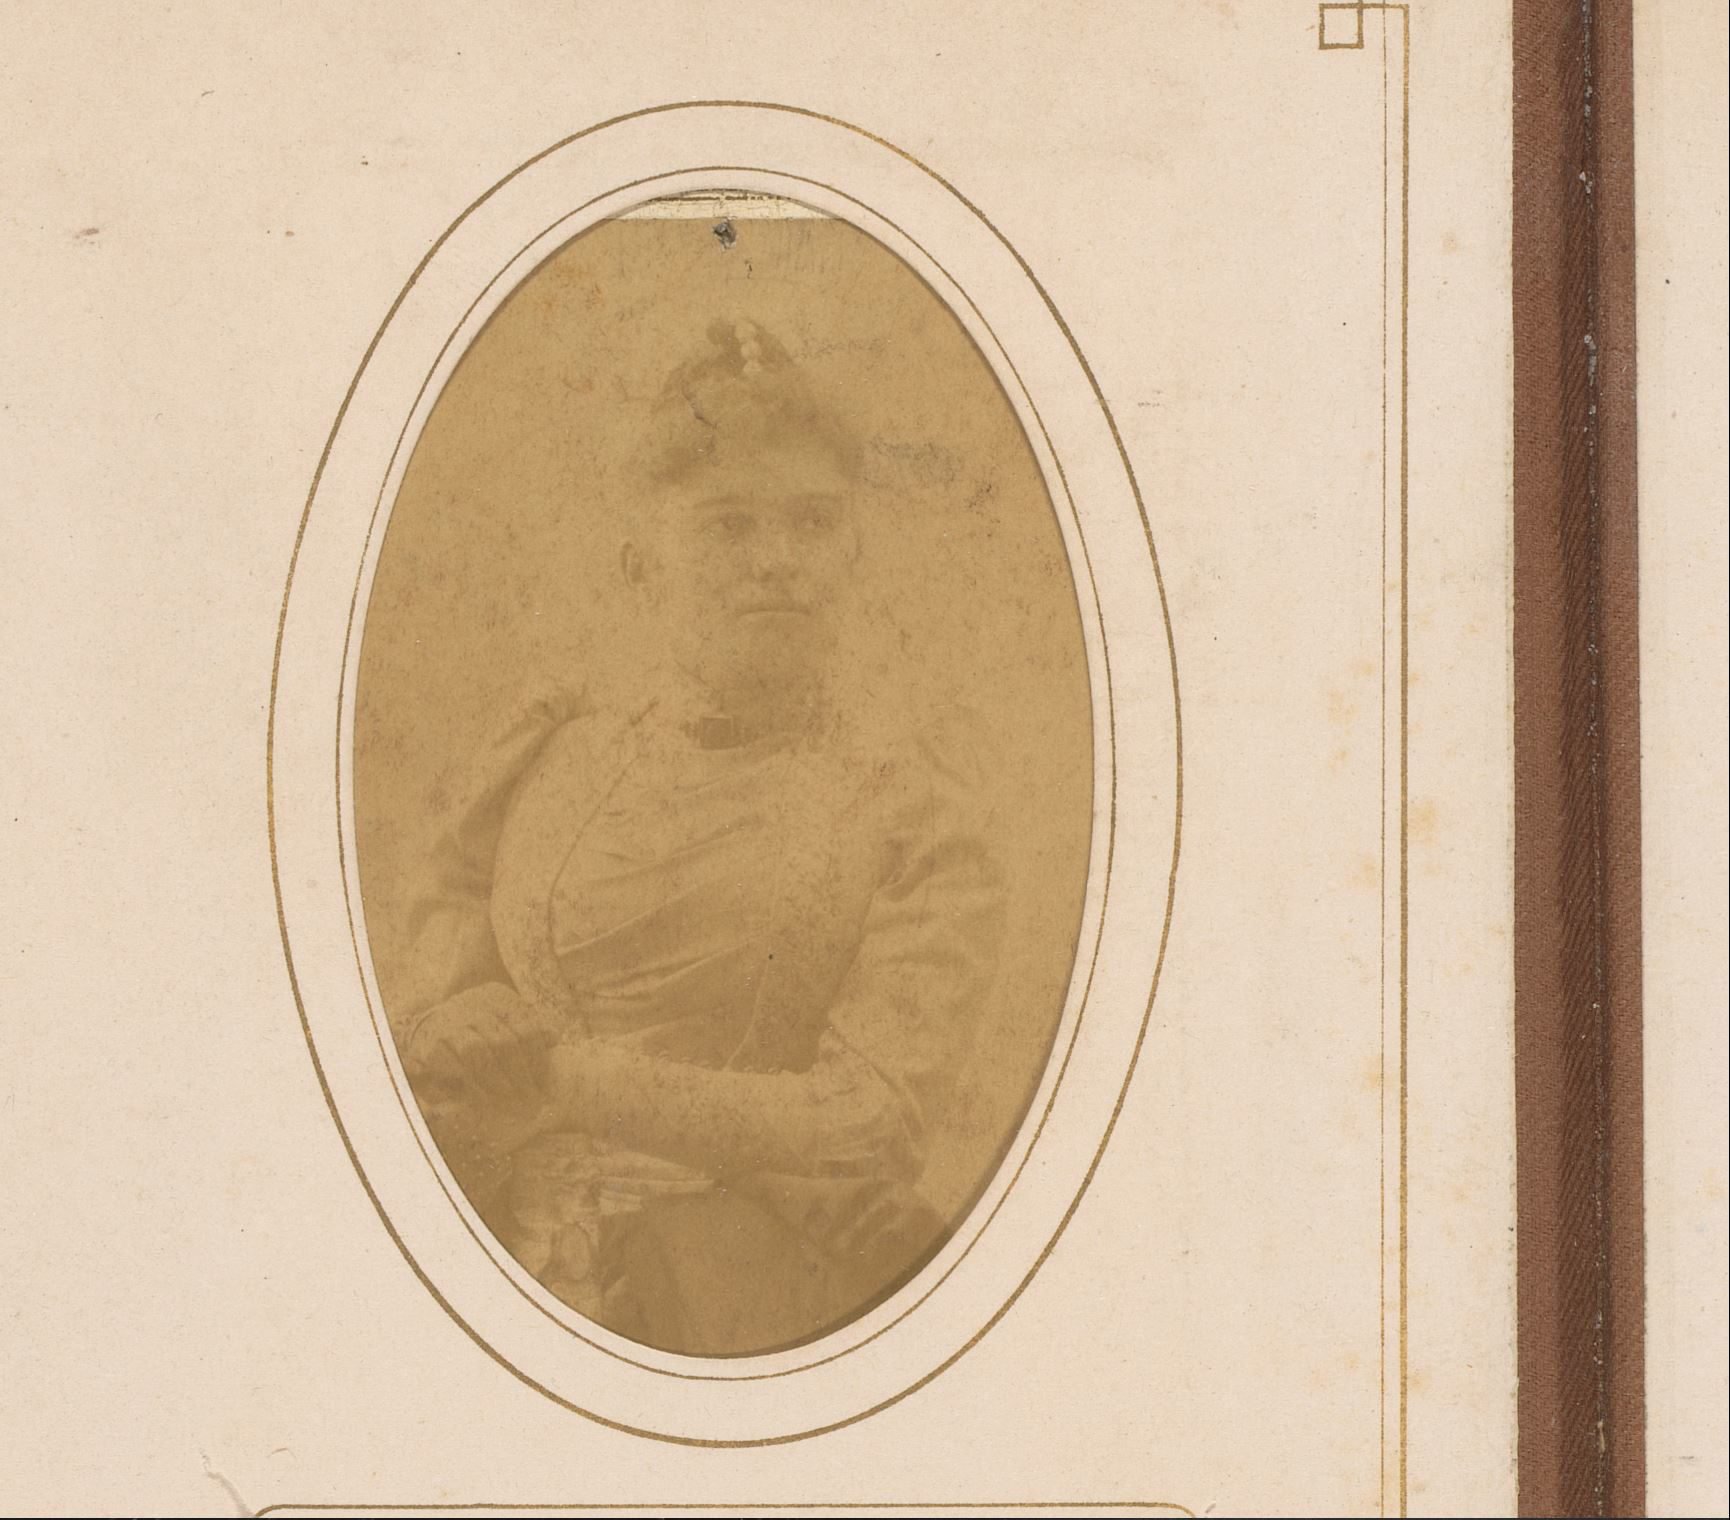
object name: cabinet photograph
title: Portret van een staande vrouw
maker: Anonymous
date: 1860-1900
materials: cardboard, photographic support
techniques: albumen print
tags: historical persons - bb - woman